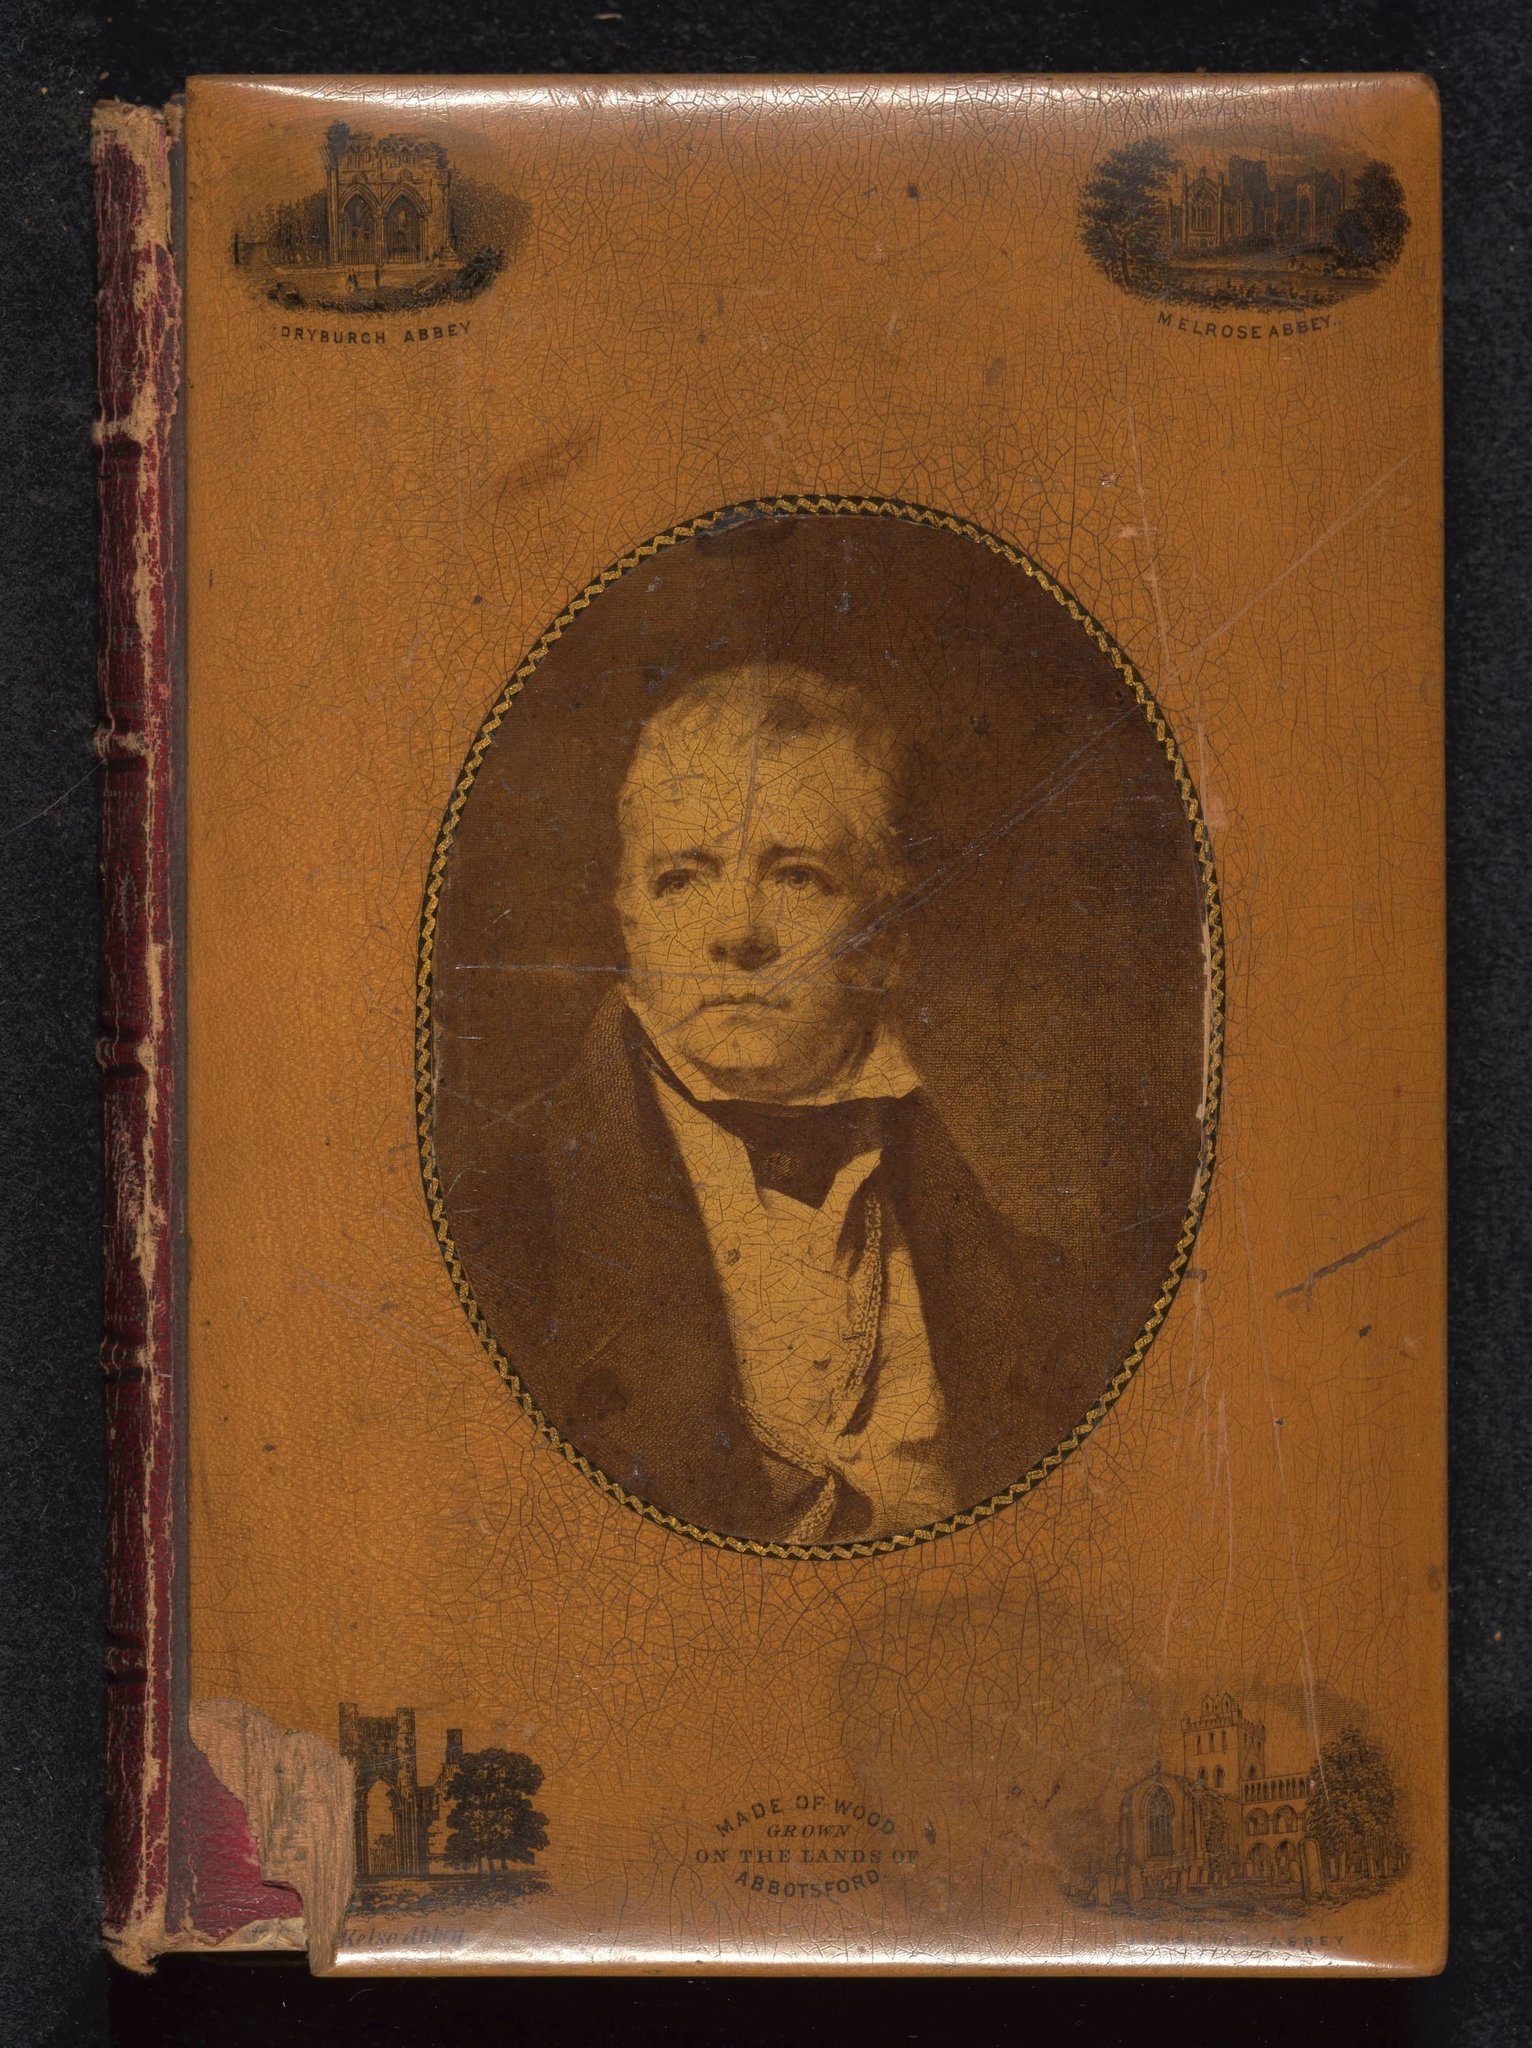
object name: reproduction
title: Fotoreproductie van een portret van Walter Scott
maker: Anonymous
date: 1861-1871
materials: photographic support, wood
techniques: albumen print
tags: walter scott, portrait of a writer